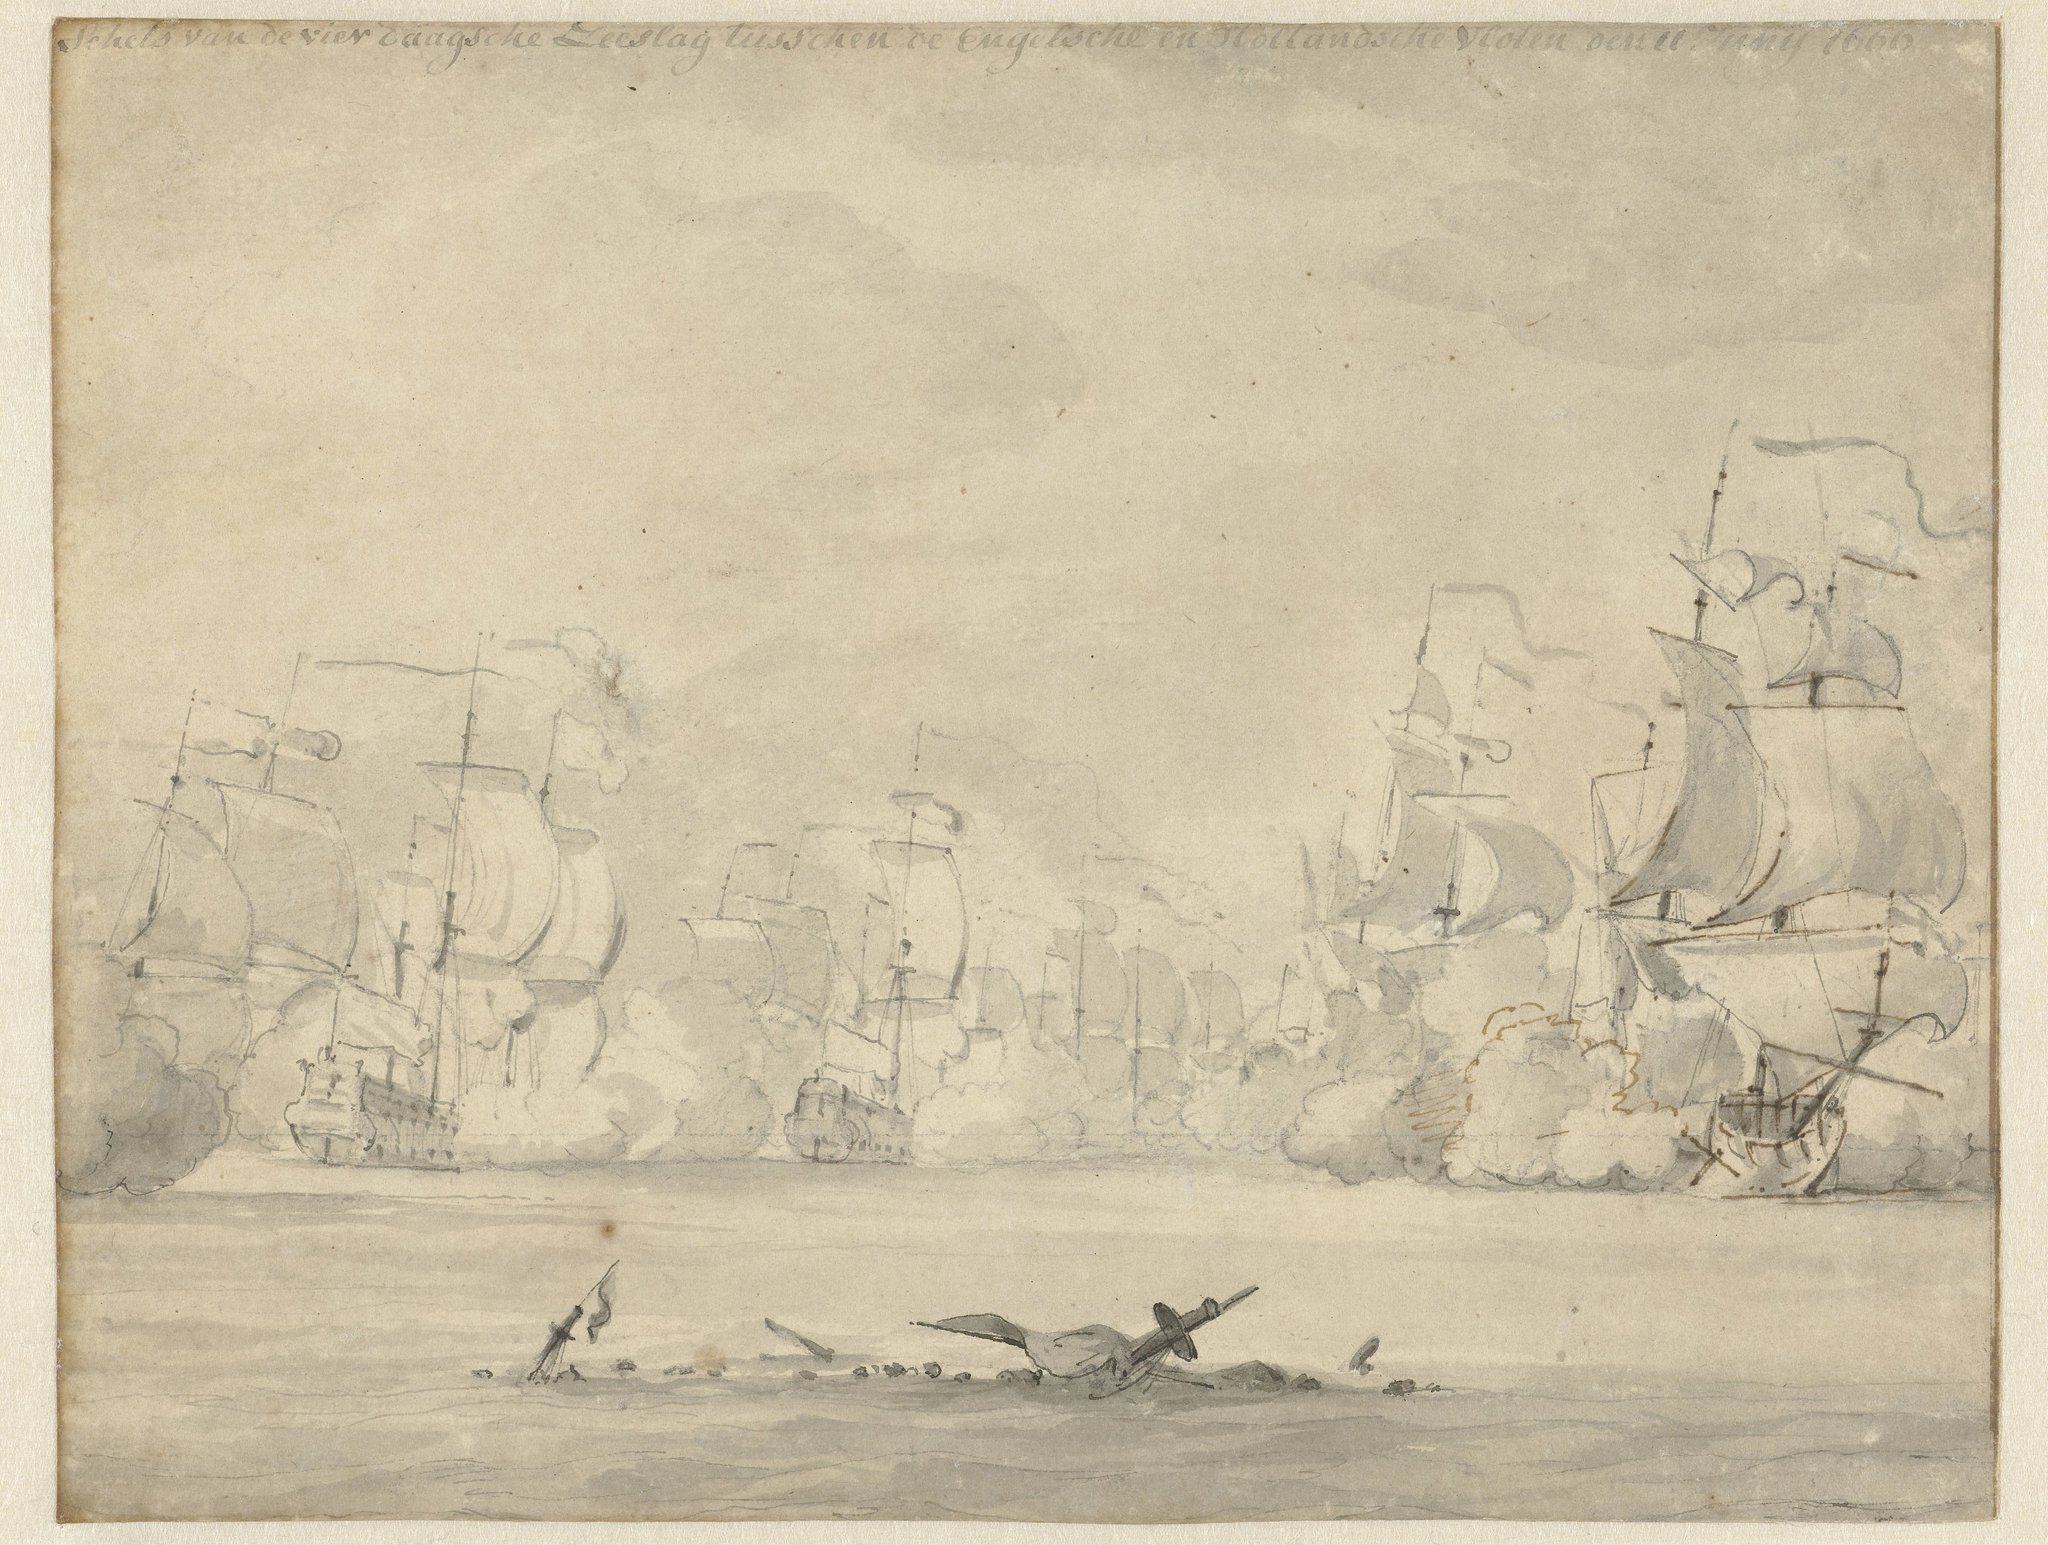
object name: drawing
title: Gevechten tijdens de eerste dag van de Vierdaagse Zeeslag, 1666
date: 1666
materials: ink, paper, pencil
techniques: brush, pen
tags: flushing, michiel adriaenszoon de ruyter, battle (+ sailing-ships), navy (+ sailing-ships)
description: De Vierdaagse Zeeslag tussen de Staatse vloot onder admiraal Michiel Adriaenszoon de Ruyter en de Engelse vloot onder admiraal George Monck, 11-14 juni 1666. Gevechten op de eerste dag: 11 juni 1666.